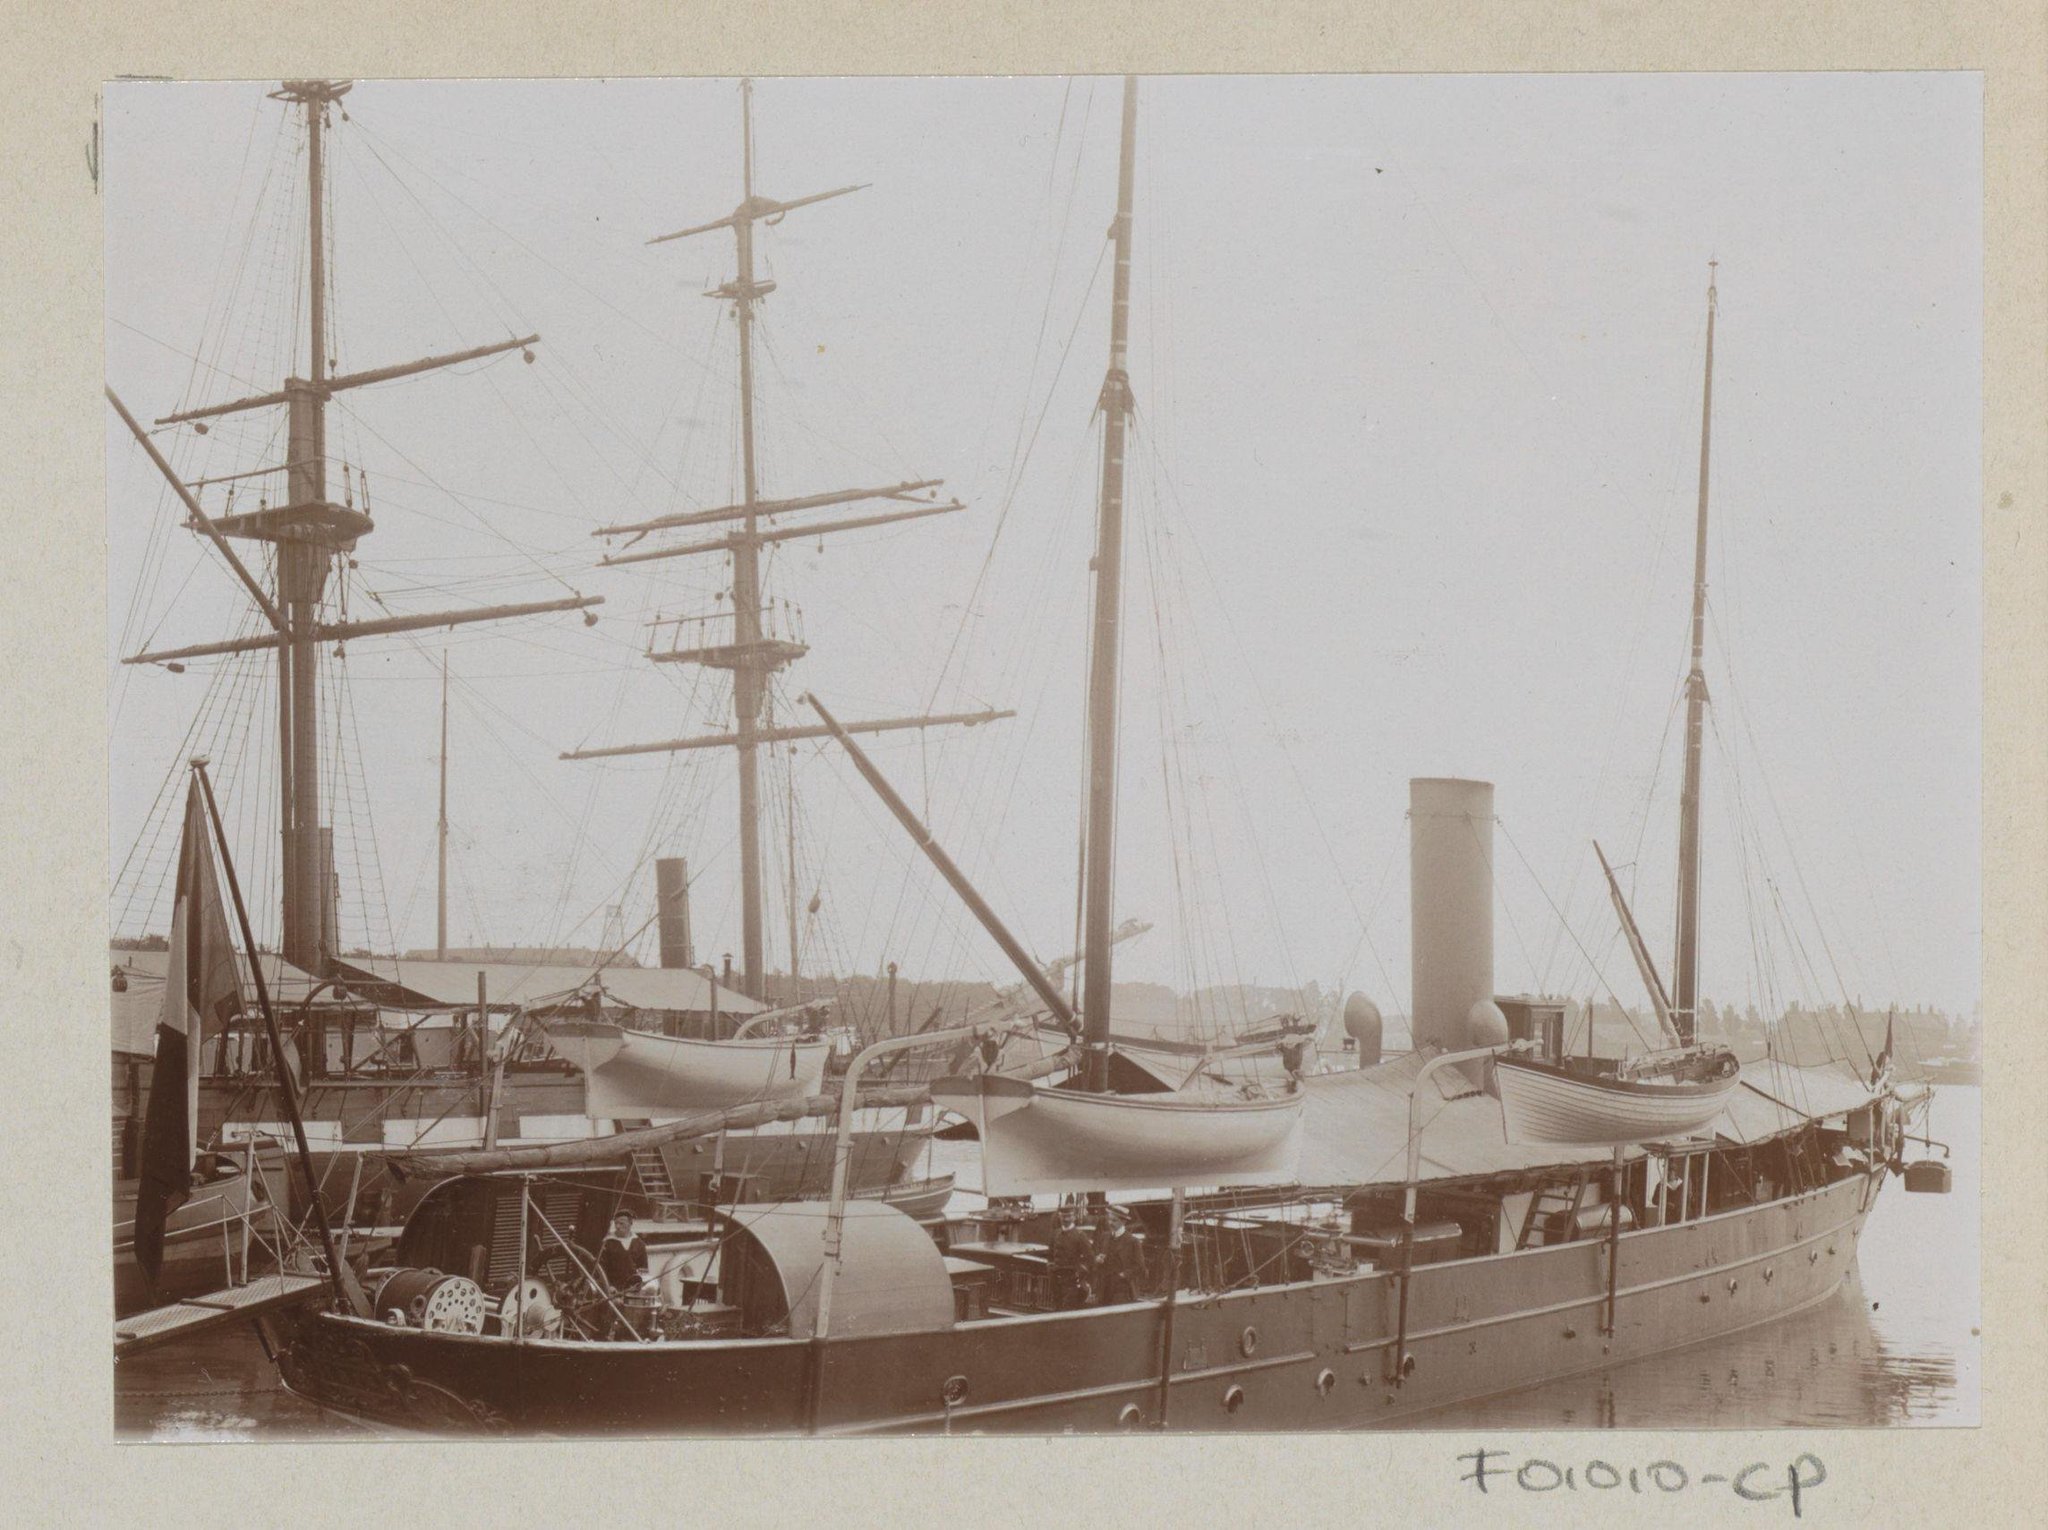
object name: photograph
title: Schip in een haven, vermoedelijk in Amsterdam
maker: Anonymous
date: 1900-1910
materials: photographic support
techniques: collodion silver print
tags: harbour, amsterdam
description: Onderdeel van Familiealbum met onder meer foto's van Wijnhandel Kraaij & Co. Bordeaux-Amsterdam.